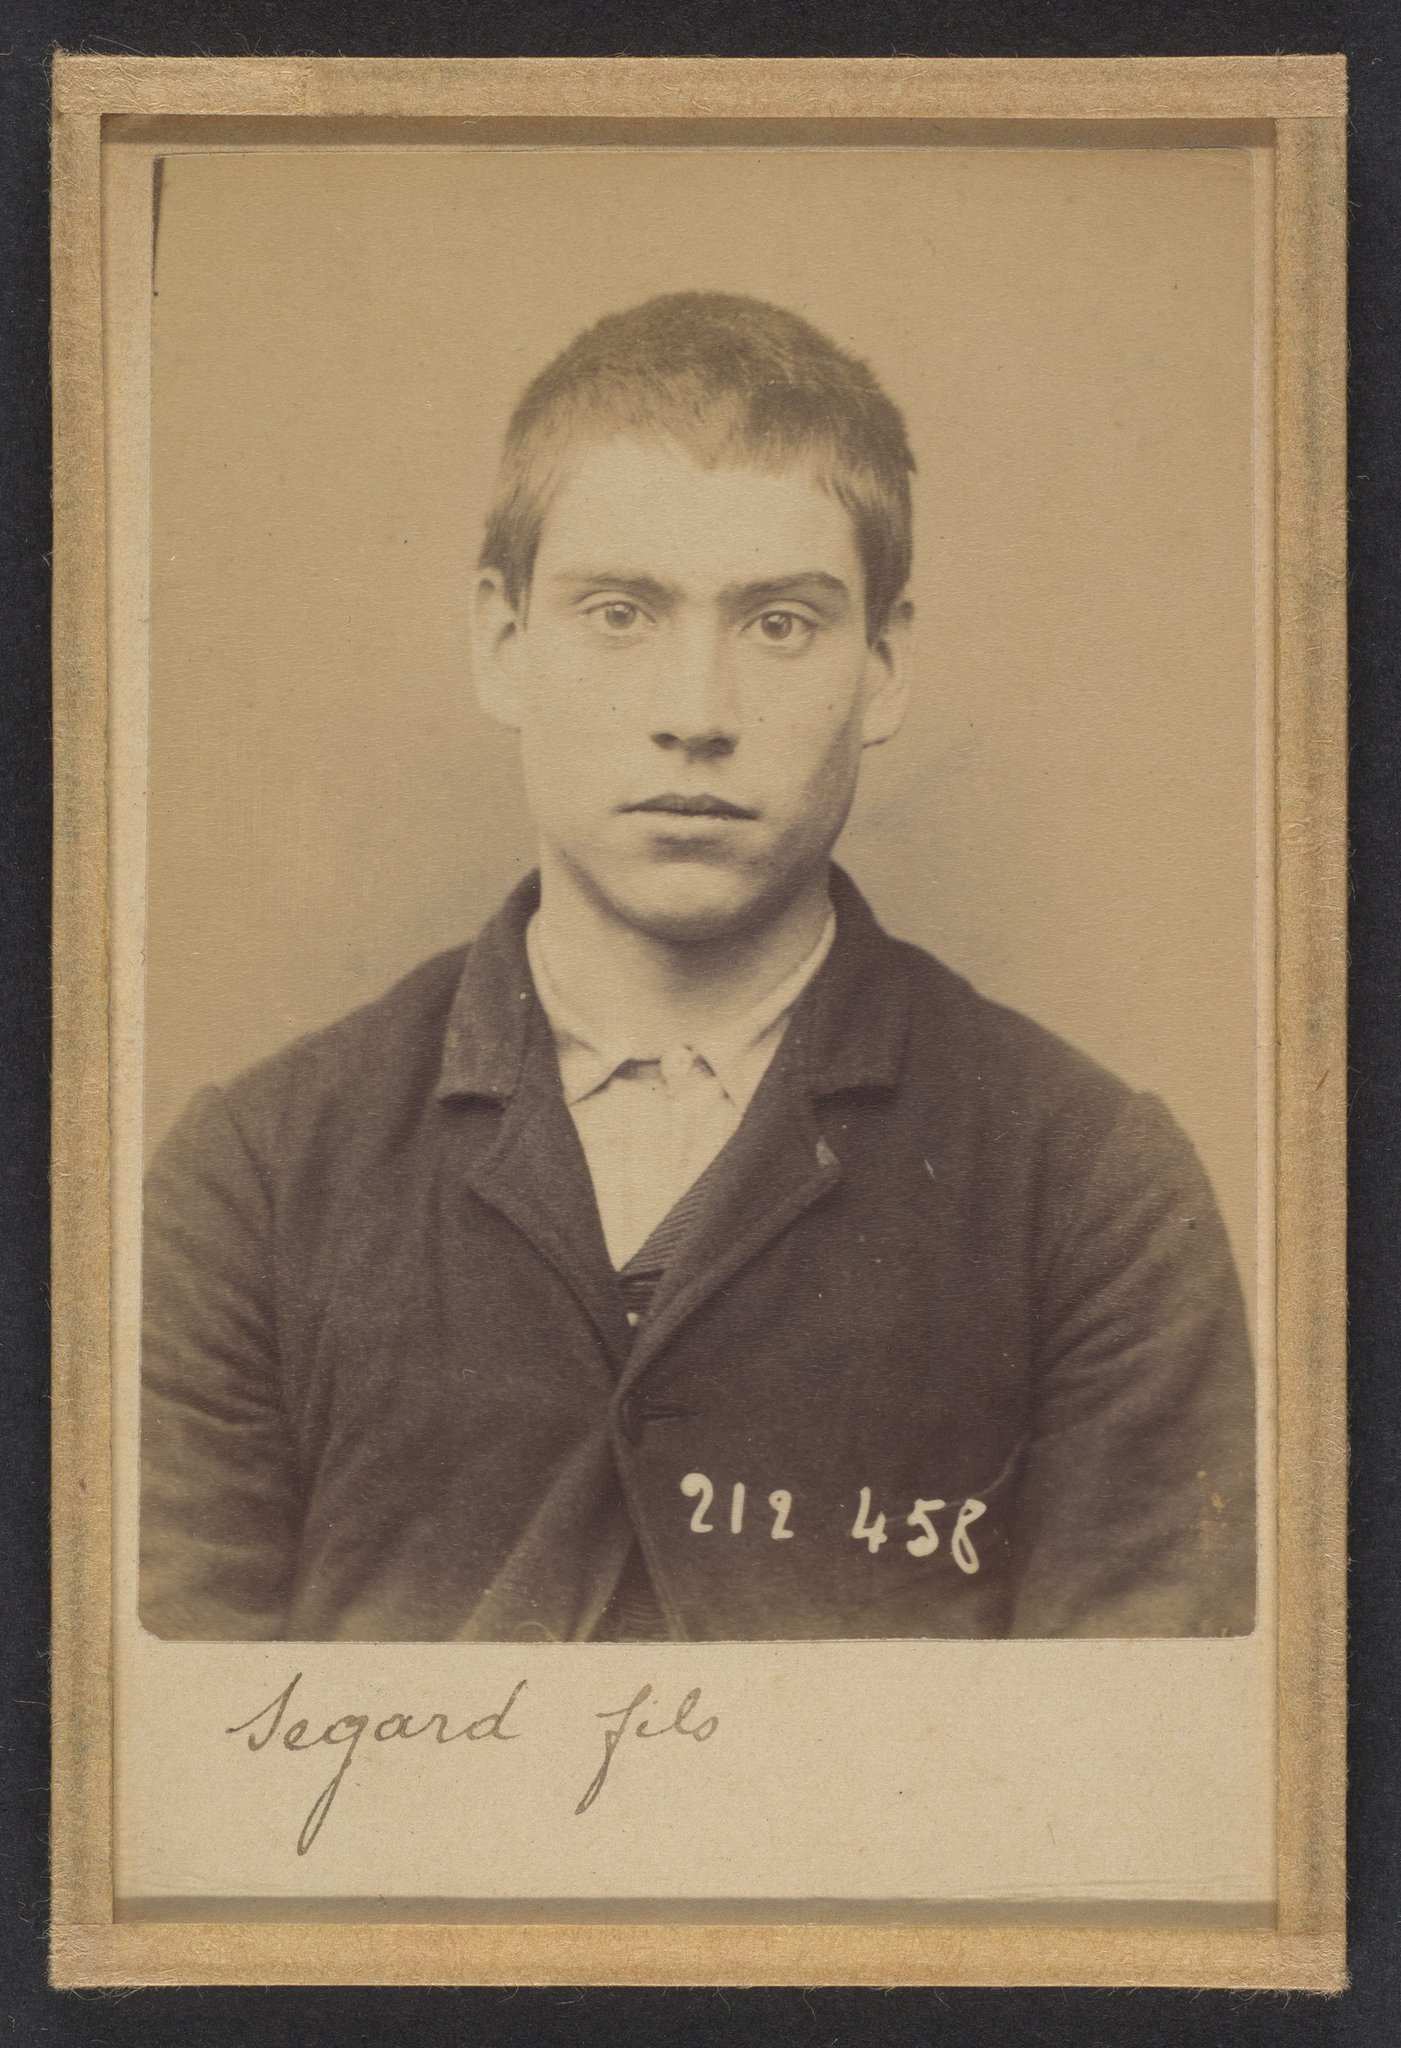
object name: mugshot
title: Segard. Émilien (dit Segard Fils). 18 ans, né à Saloüel (Somme). Peintre en voitures. Anarchiste. 2/7/94.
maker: alphonse bertillon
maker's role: artist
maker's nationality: french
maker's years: 1853-1914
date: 1894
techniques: albumen silver print, glass negative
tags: men,portraits